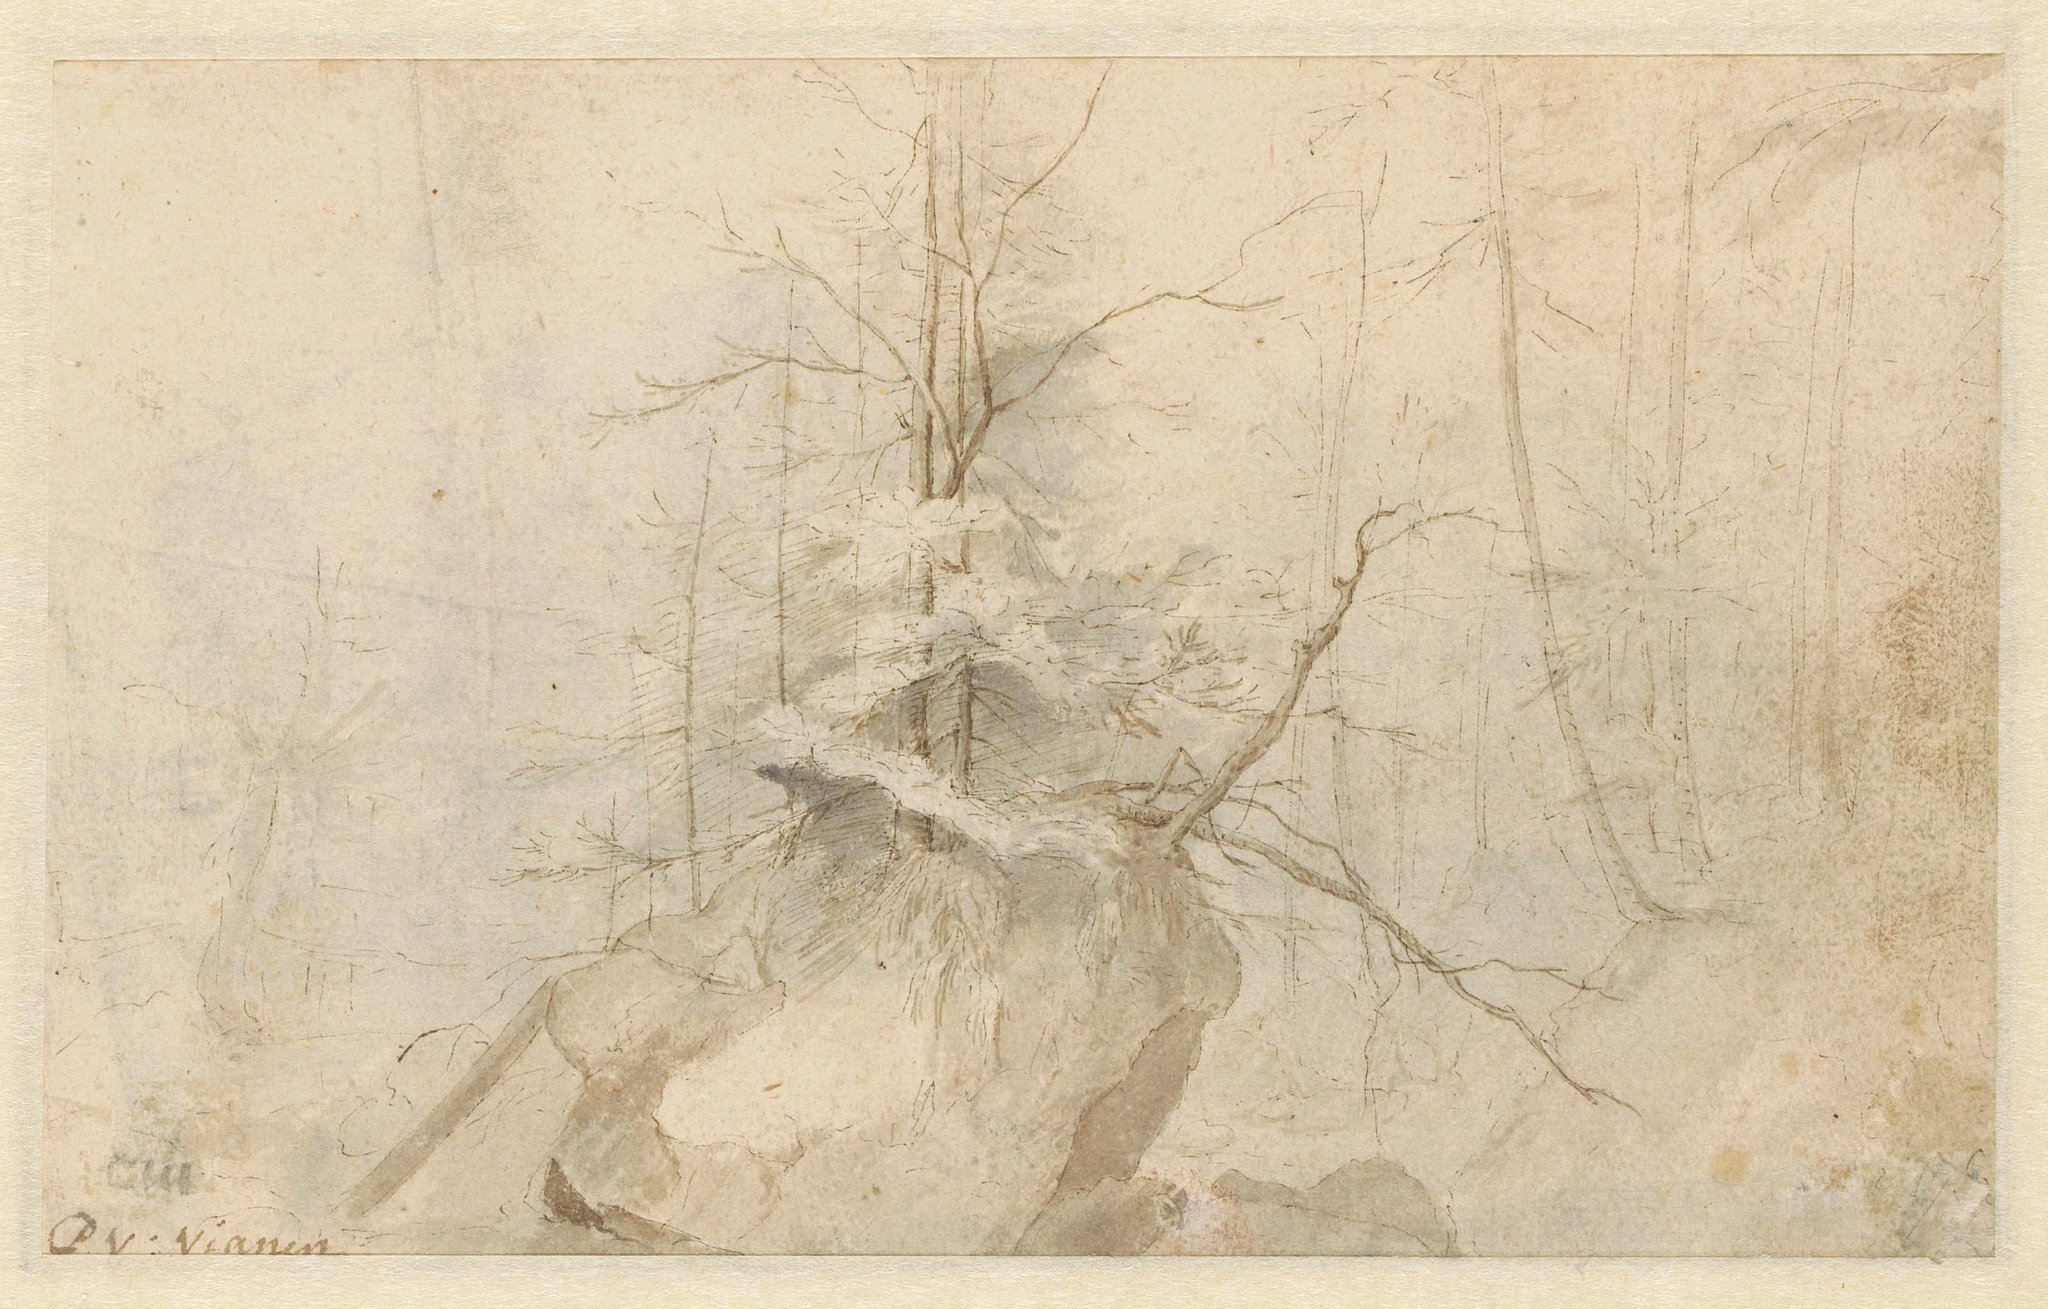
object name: drawing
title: Rocky Landscape with Trees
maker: paulus willemsz. van vianen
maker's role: draughtsman, jeweler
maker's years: 1570-1614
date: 1603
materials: ink, paper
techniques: brush, pen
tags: trees, forest, wood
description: Paulus van Vianen’s many landscape drawings are usually recognisable by their delicate penwork. With a brush he added washes of brown or grey ink –and sometimes soft pink or blue-green – to create dream-like vistas. This drawing most likely comes from the same sketchbook as the other work by Van Vianen on display on this wall.